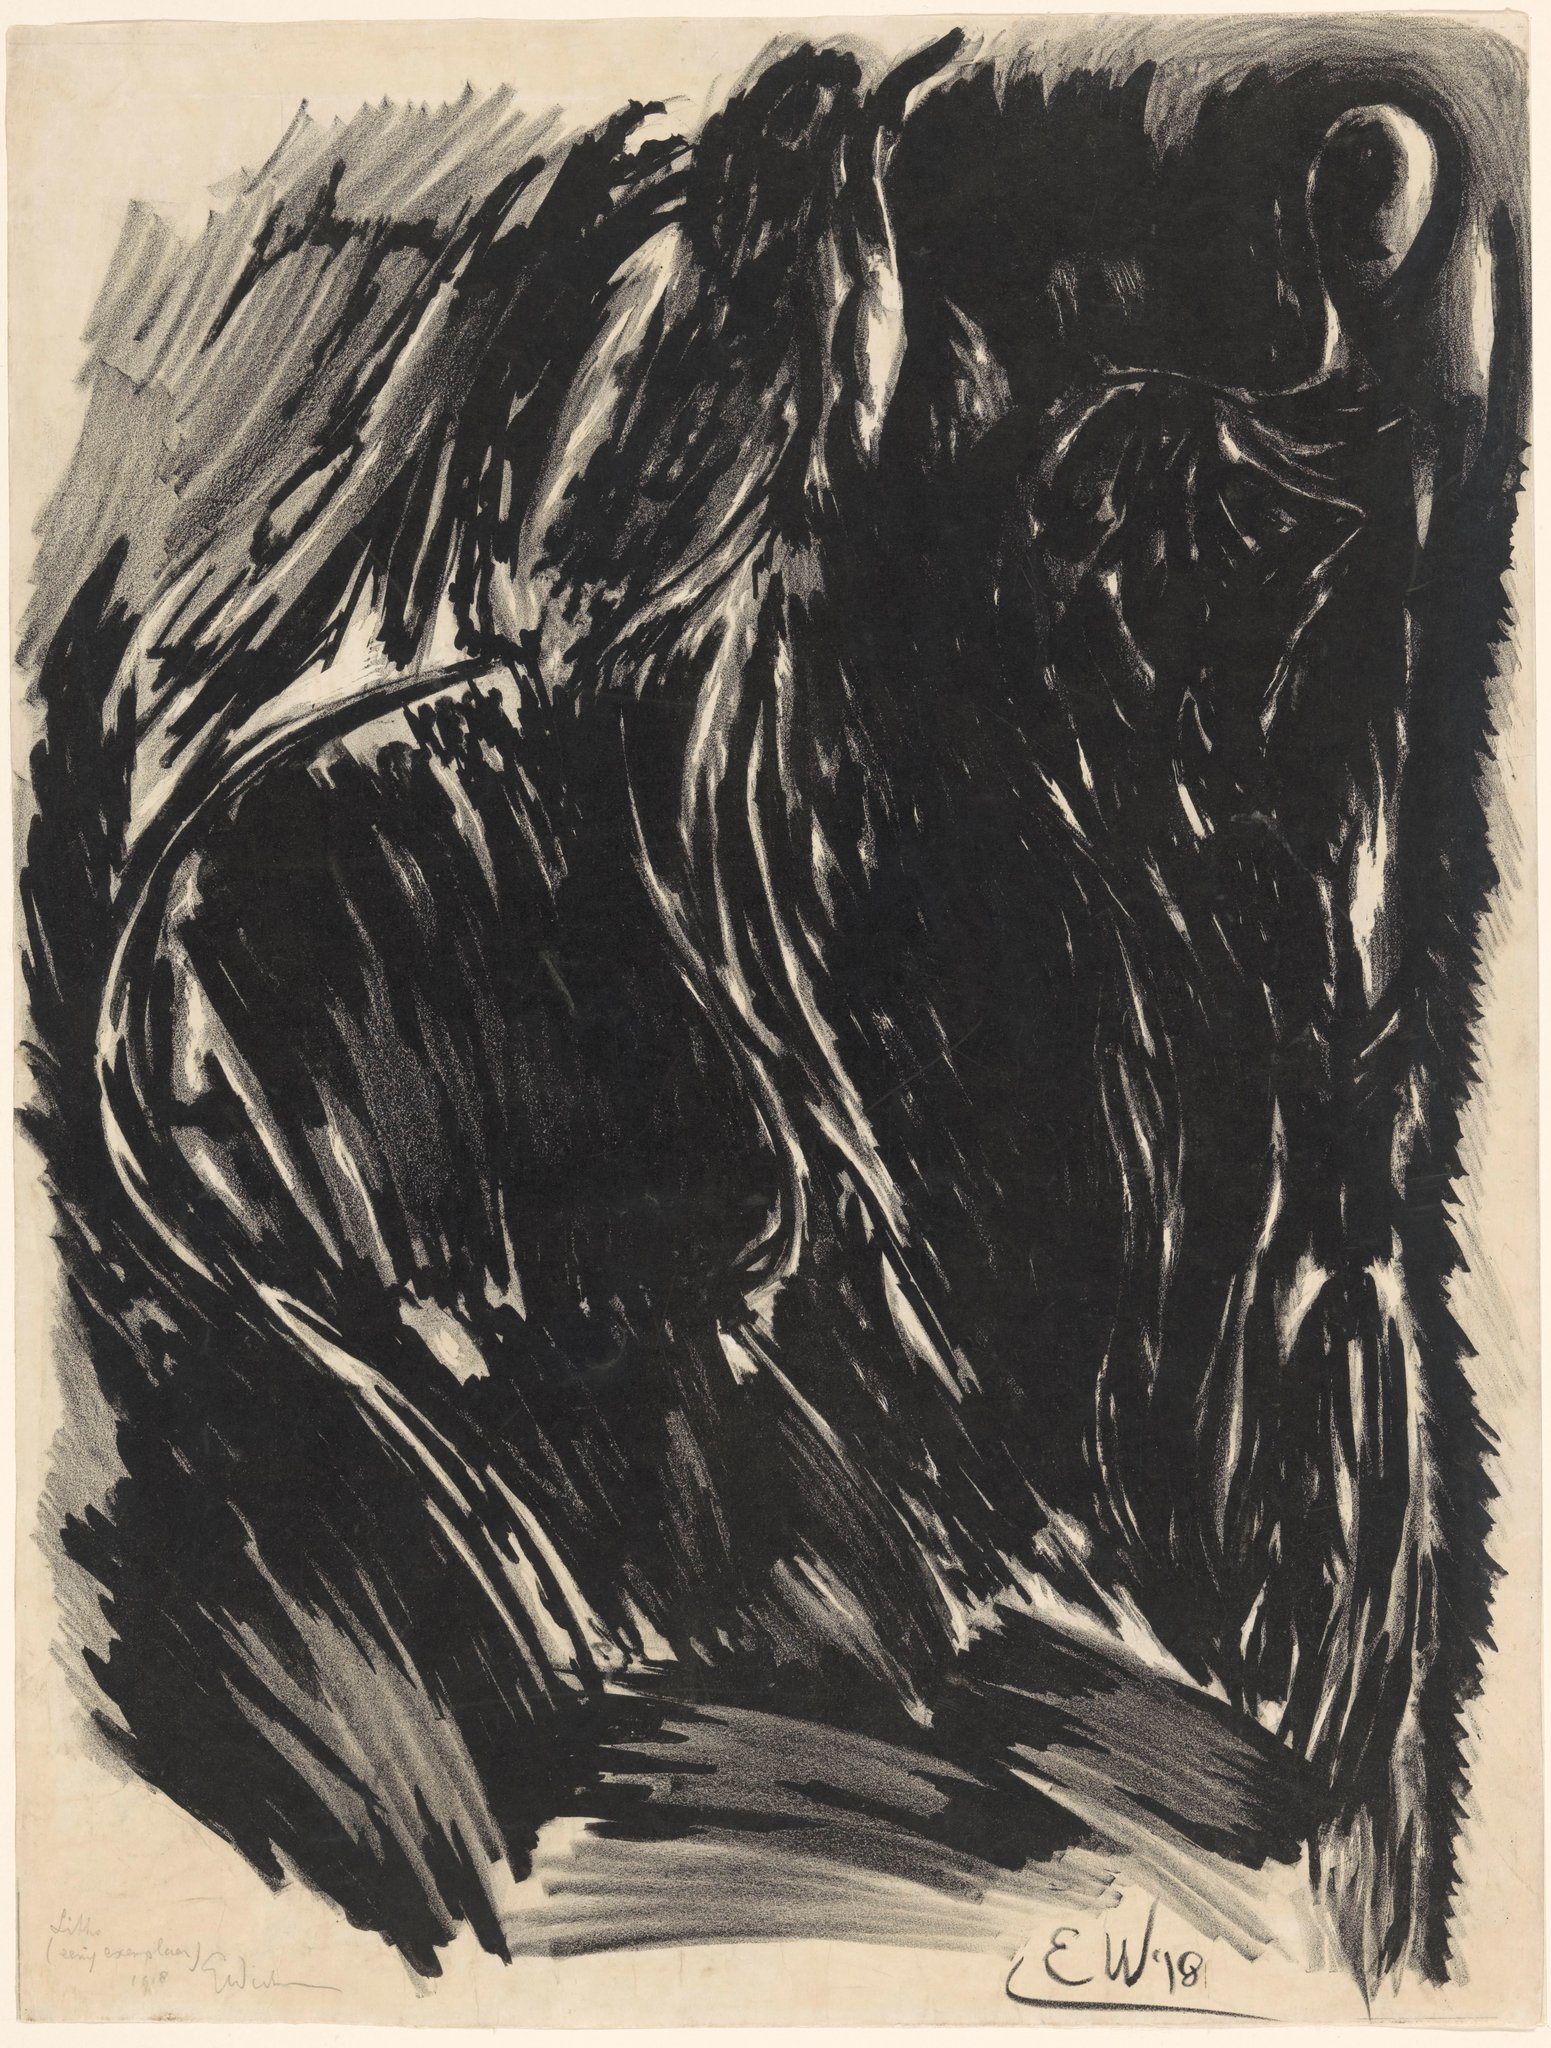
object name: print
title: Groote litho, eenig exemplaar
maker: erich wichmann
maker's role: print maker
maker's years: 1890-1929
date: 1918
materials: paper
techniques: lithograph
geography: netherlands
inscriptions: date